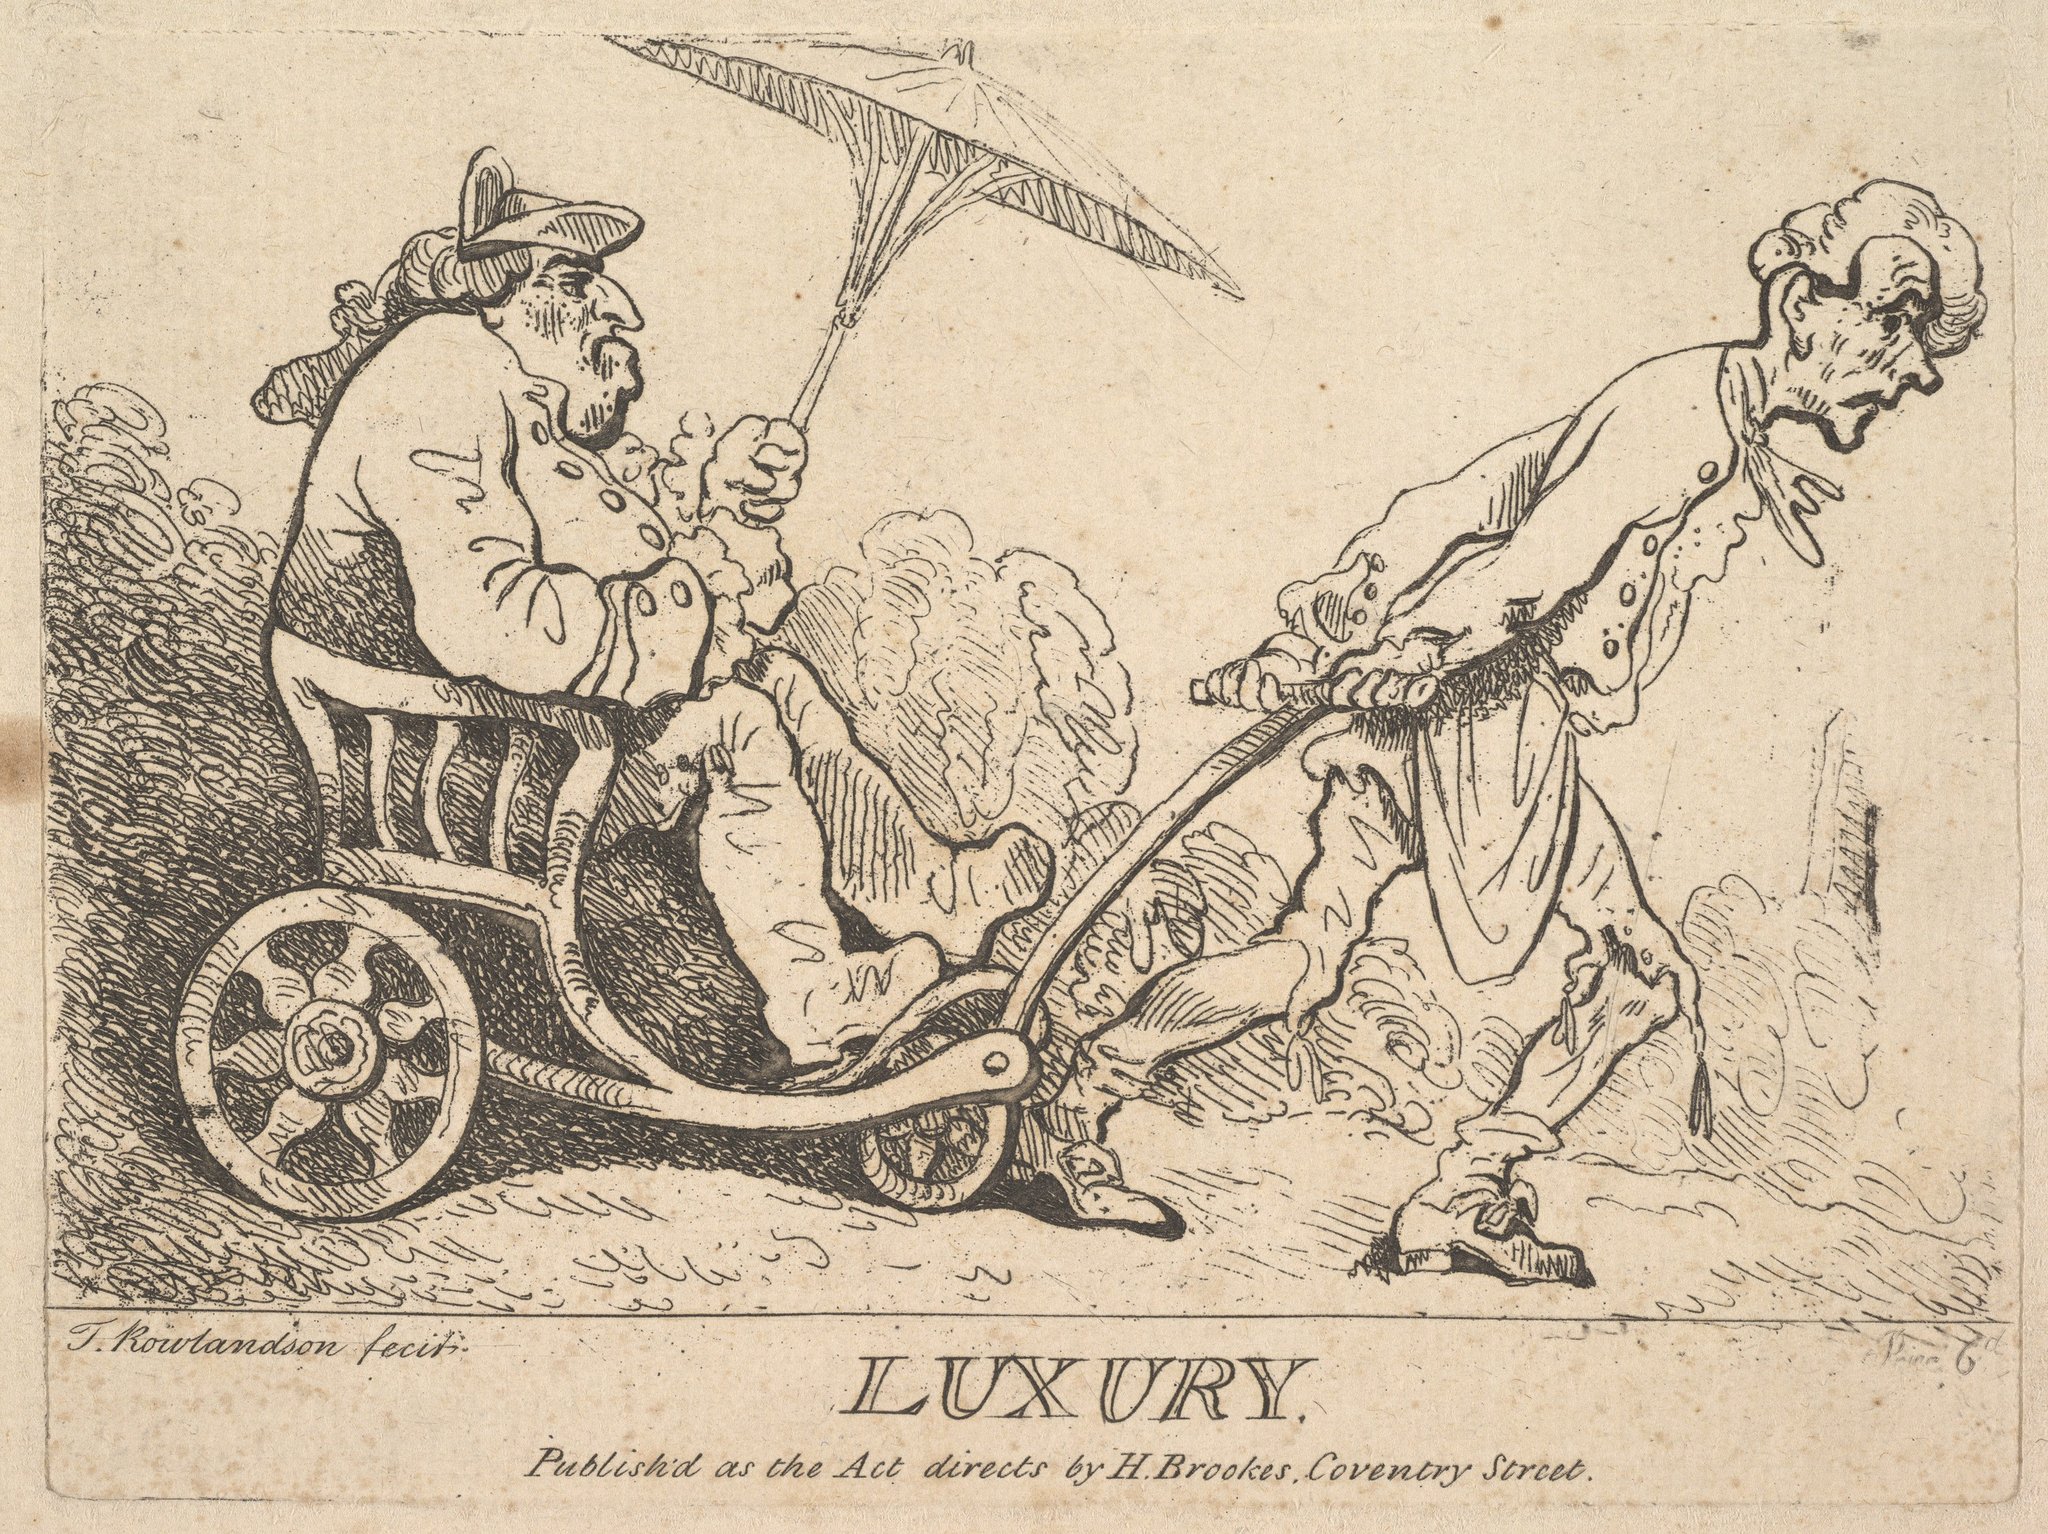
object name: print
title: Luxury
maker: thomas rowlandson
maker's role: artist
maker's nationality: british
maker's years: 1757-1827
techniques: etching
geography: england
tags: satire,men,umbrellas